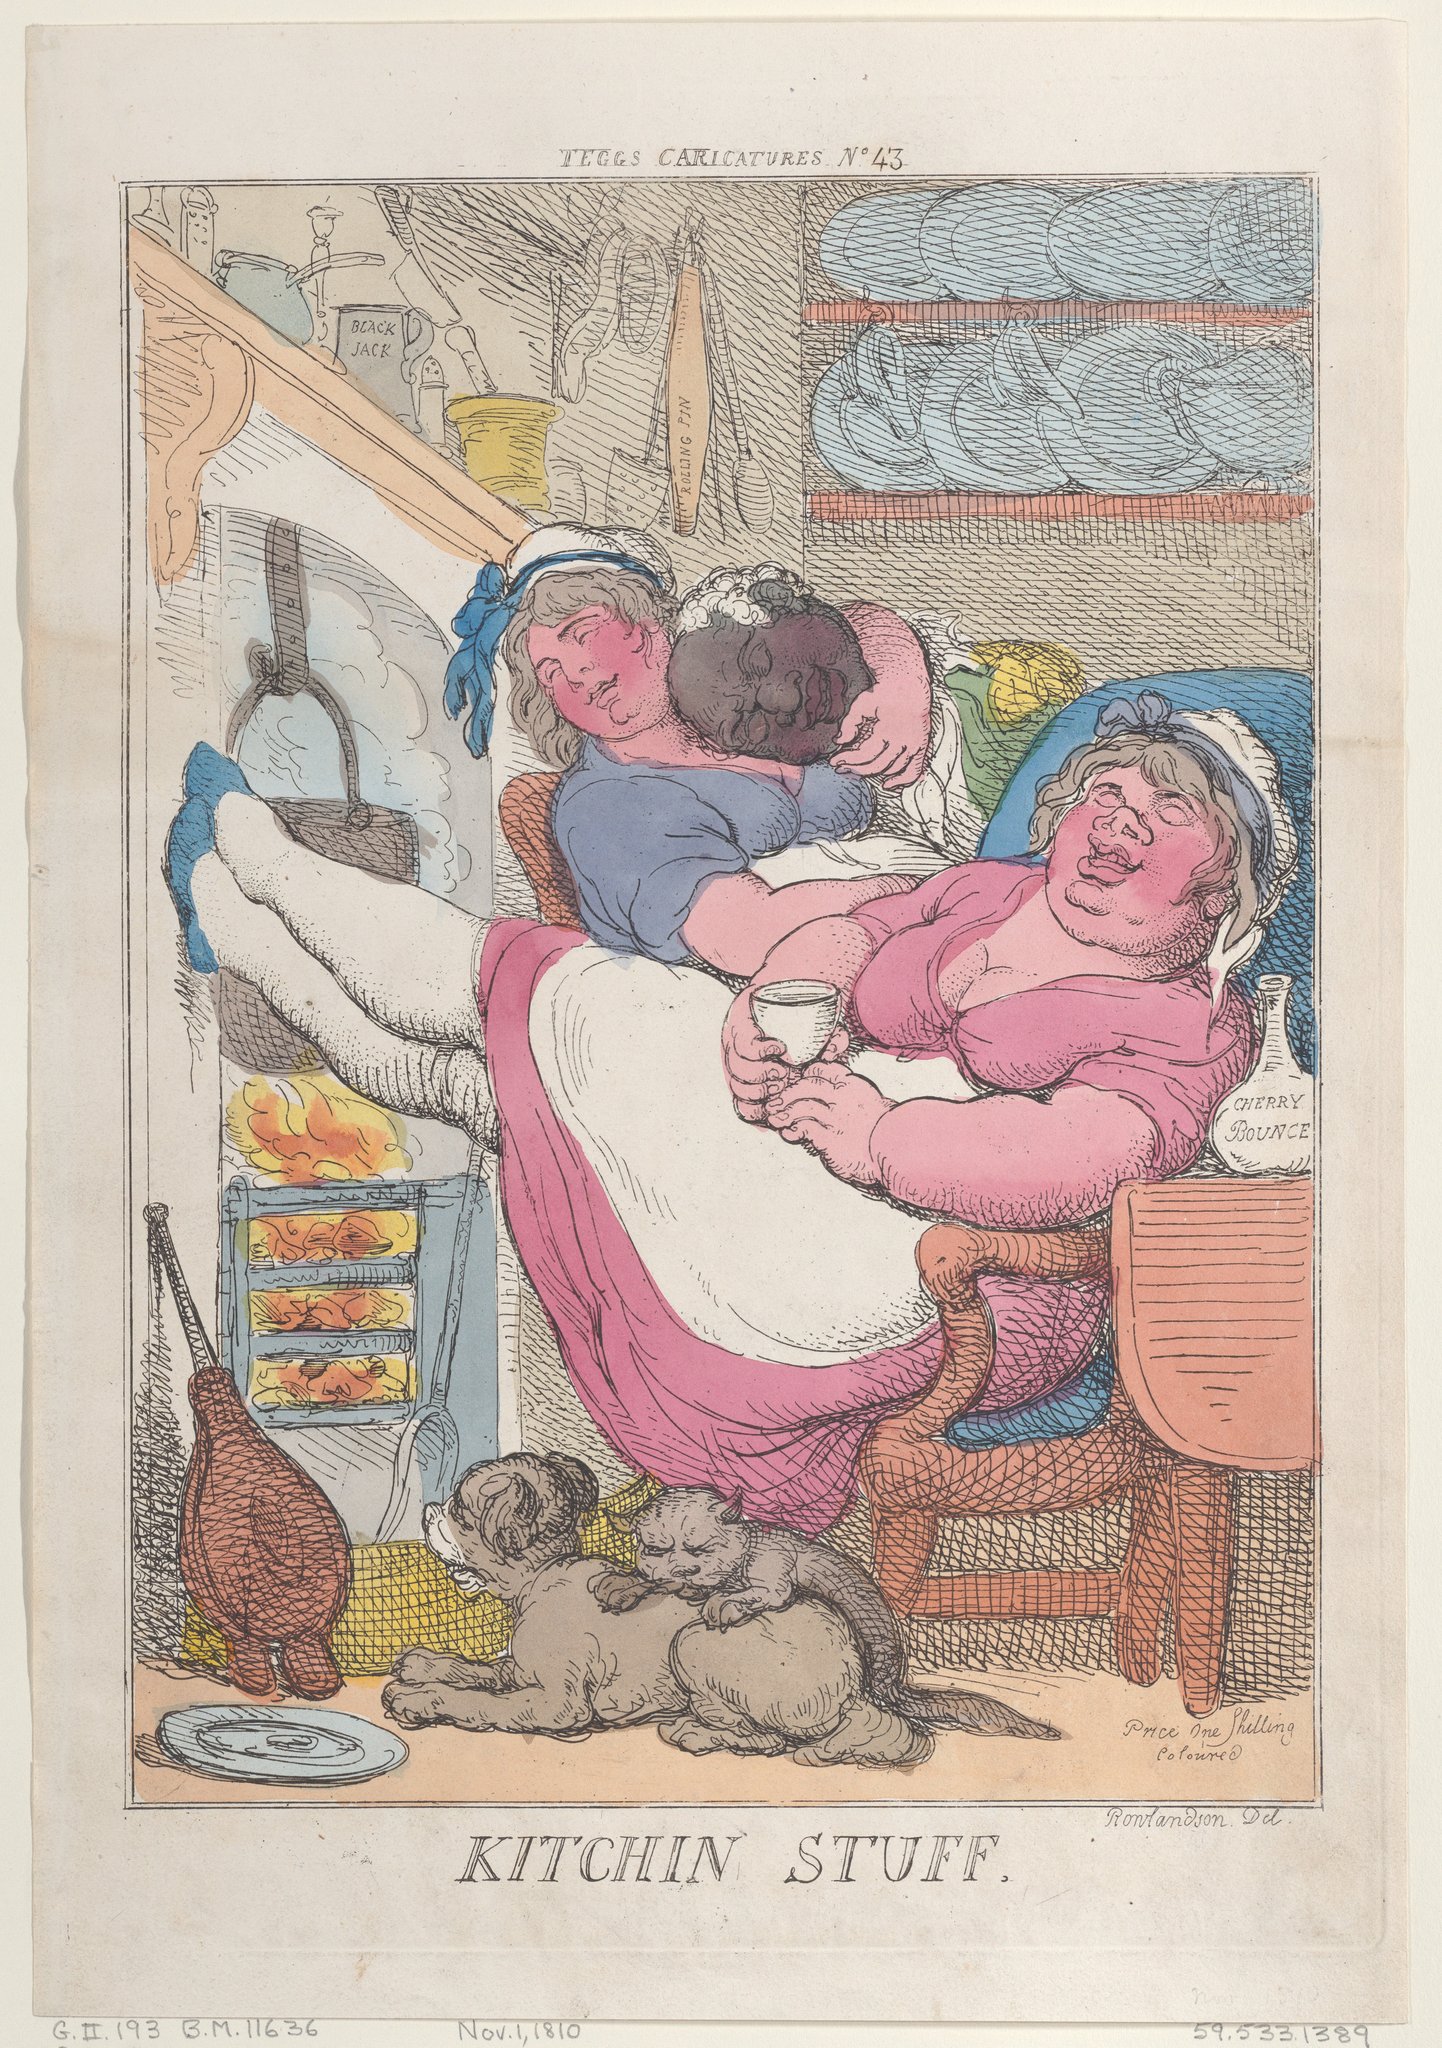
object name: print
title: Kitchin Stuff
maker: thomas rowlandson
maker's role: artist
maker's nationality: british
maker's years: 1757-1827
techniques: etching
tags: satire,sleeping,men,women,cats,dogs,drinking,servants